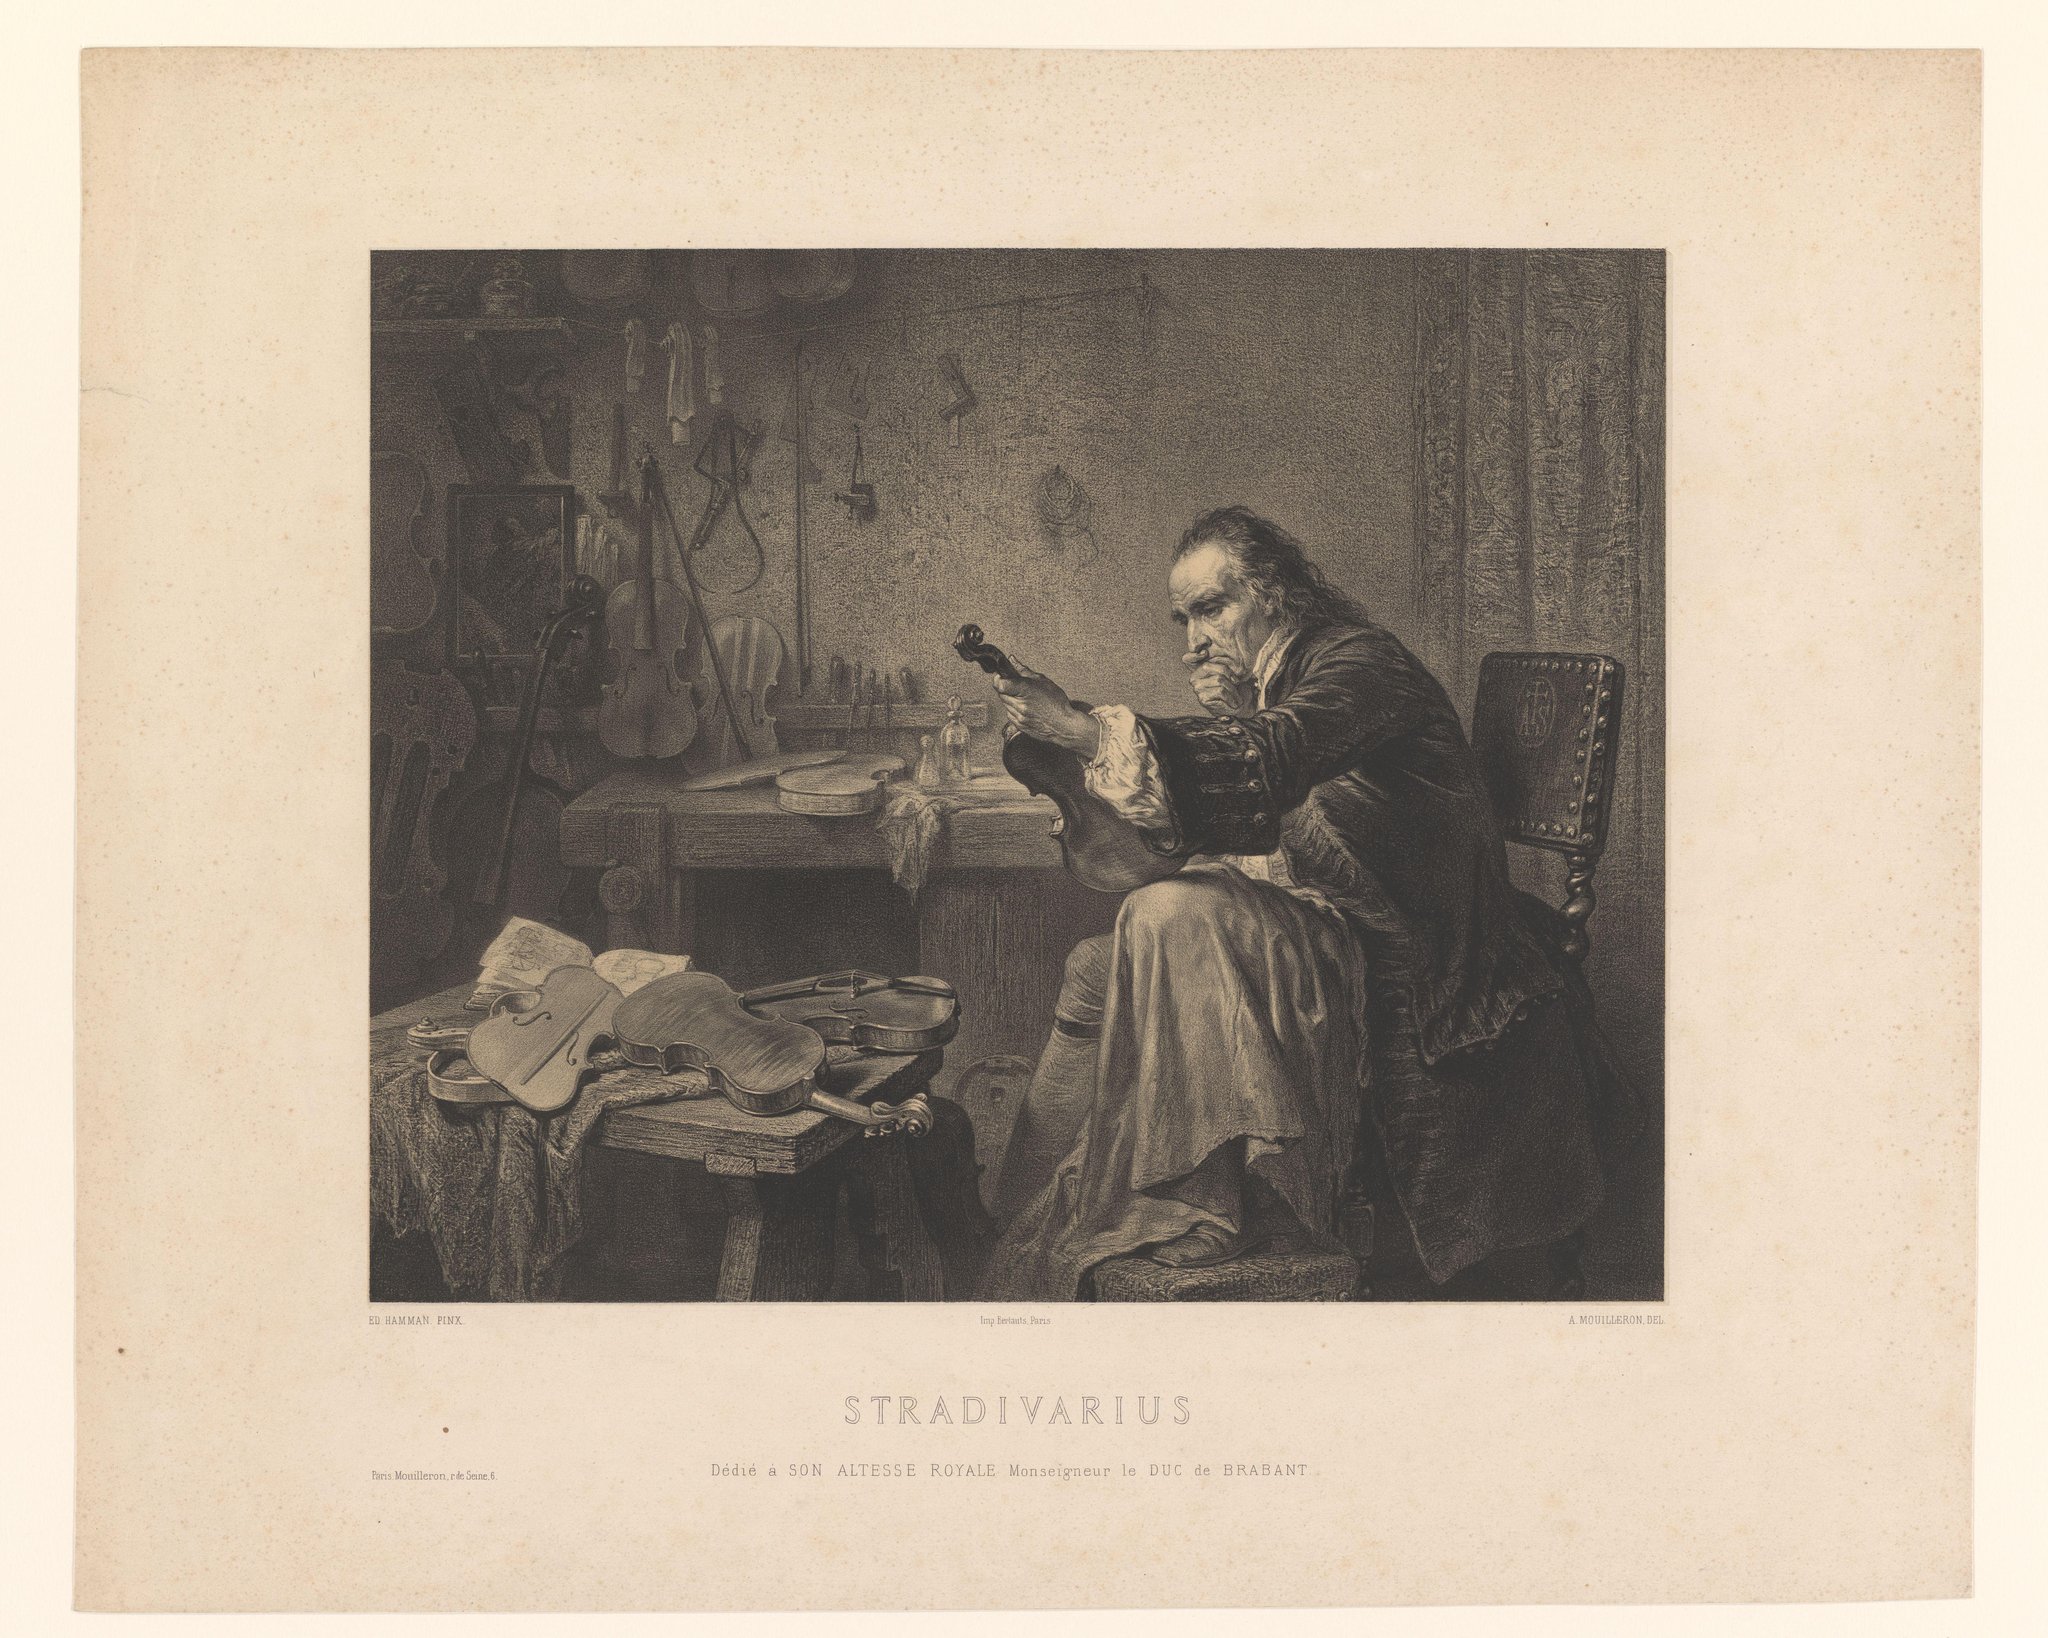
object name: print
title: Antonio Stradivari in zijn atelier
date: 1863-1880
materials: paper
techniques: tone lithography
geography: paris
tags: historical persons, violin, fiddle, tools, implements of craftsman, string instruments (bowed)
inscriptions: check stamp: Lugt 4789, collector's mark: Lugt 2228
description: De vioolbouwer Antonio Stradivari geportretteerd in zijn werkplaats. Hij zit aan zijn werktafel en bekijkt in peinzende houding een viool die hij op zijn linkerknie steunt. Op de tafel en een bankje violen, onderdelen van violen en open schetsboek. Links in de hoek staat een cello. Aan de muur hangen violen en hangt gereedschap.